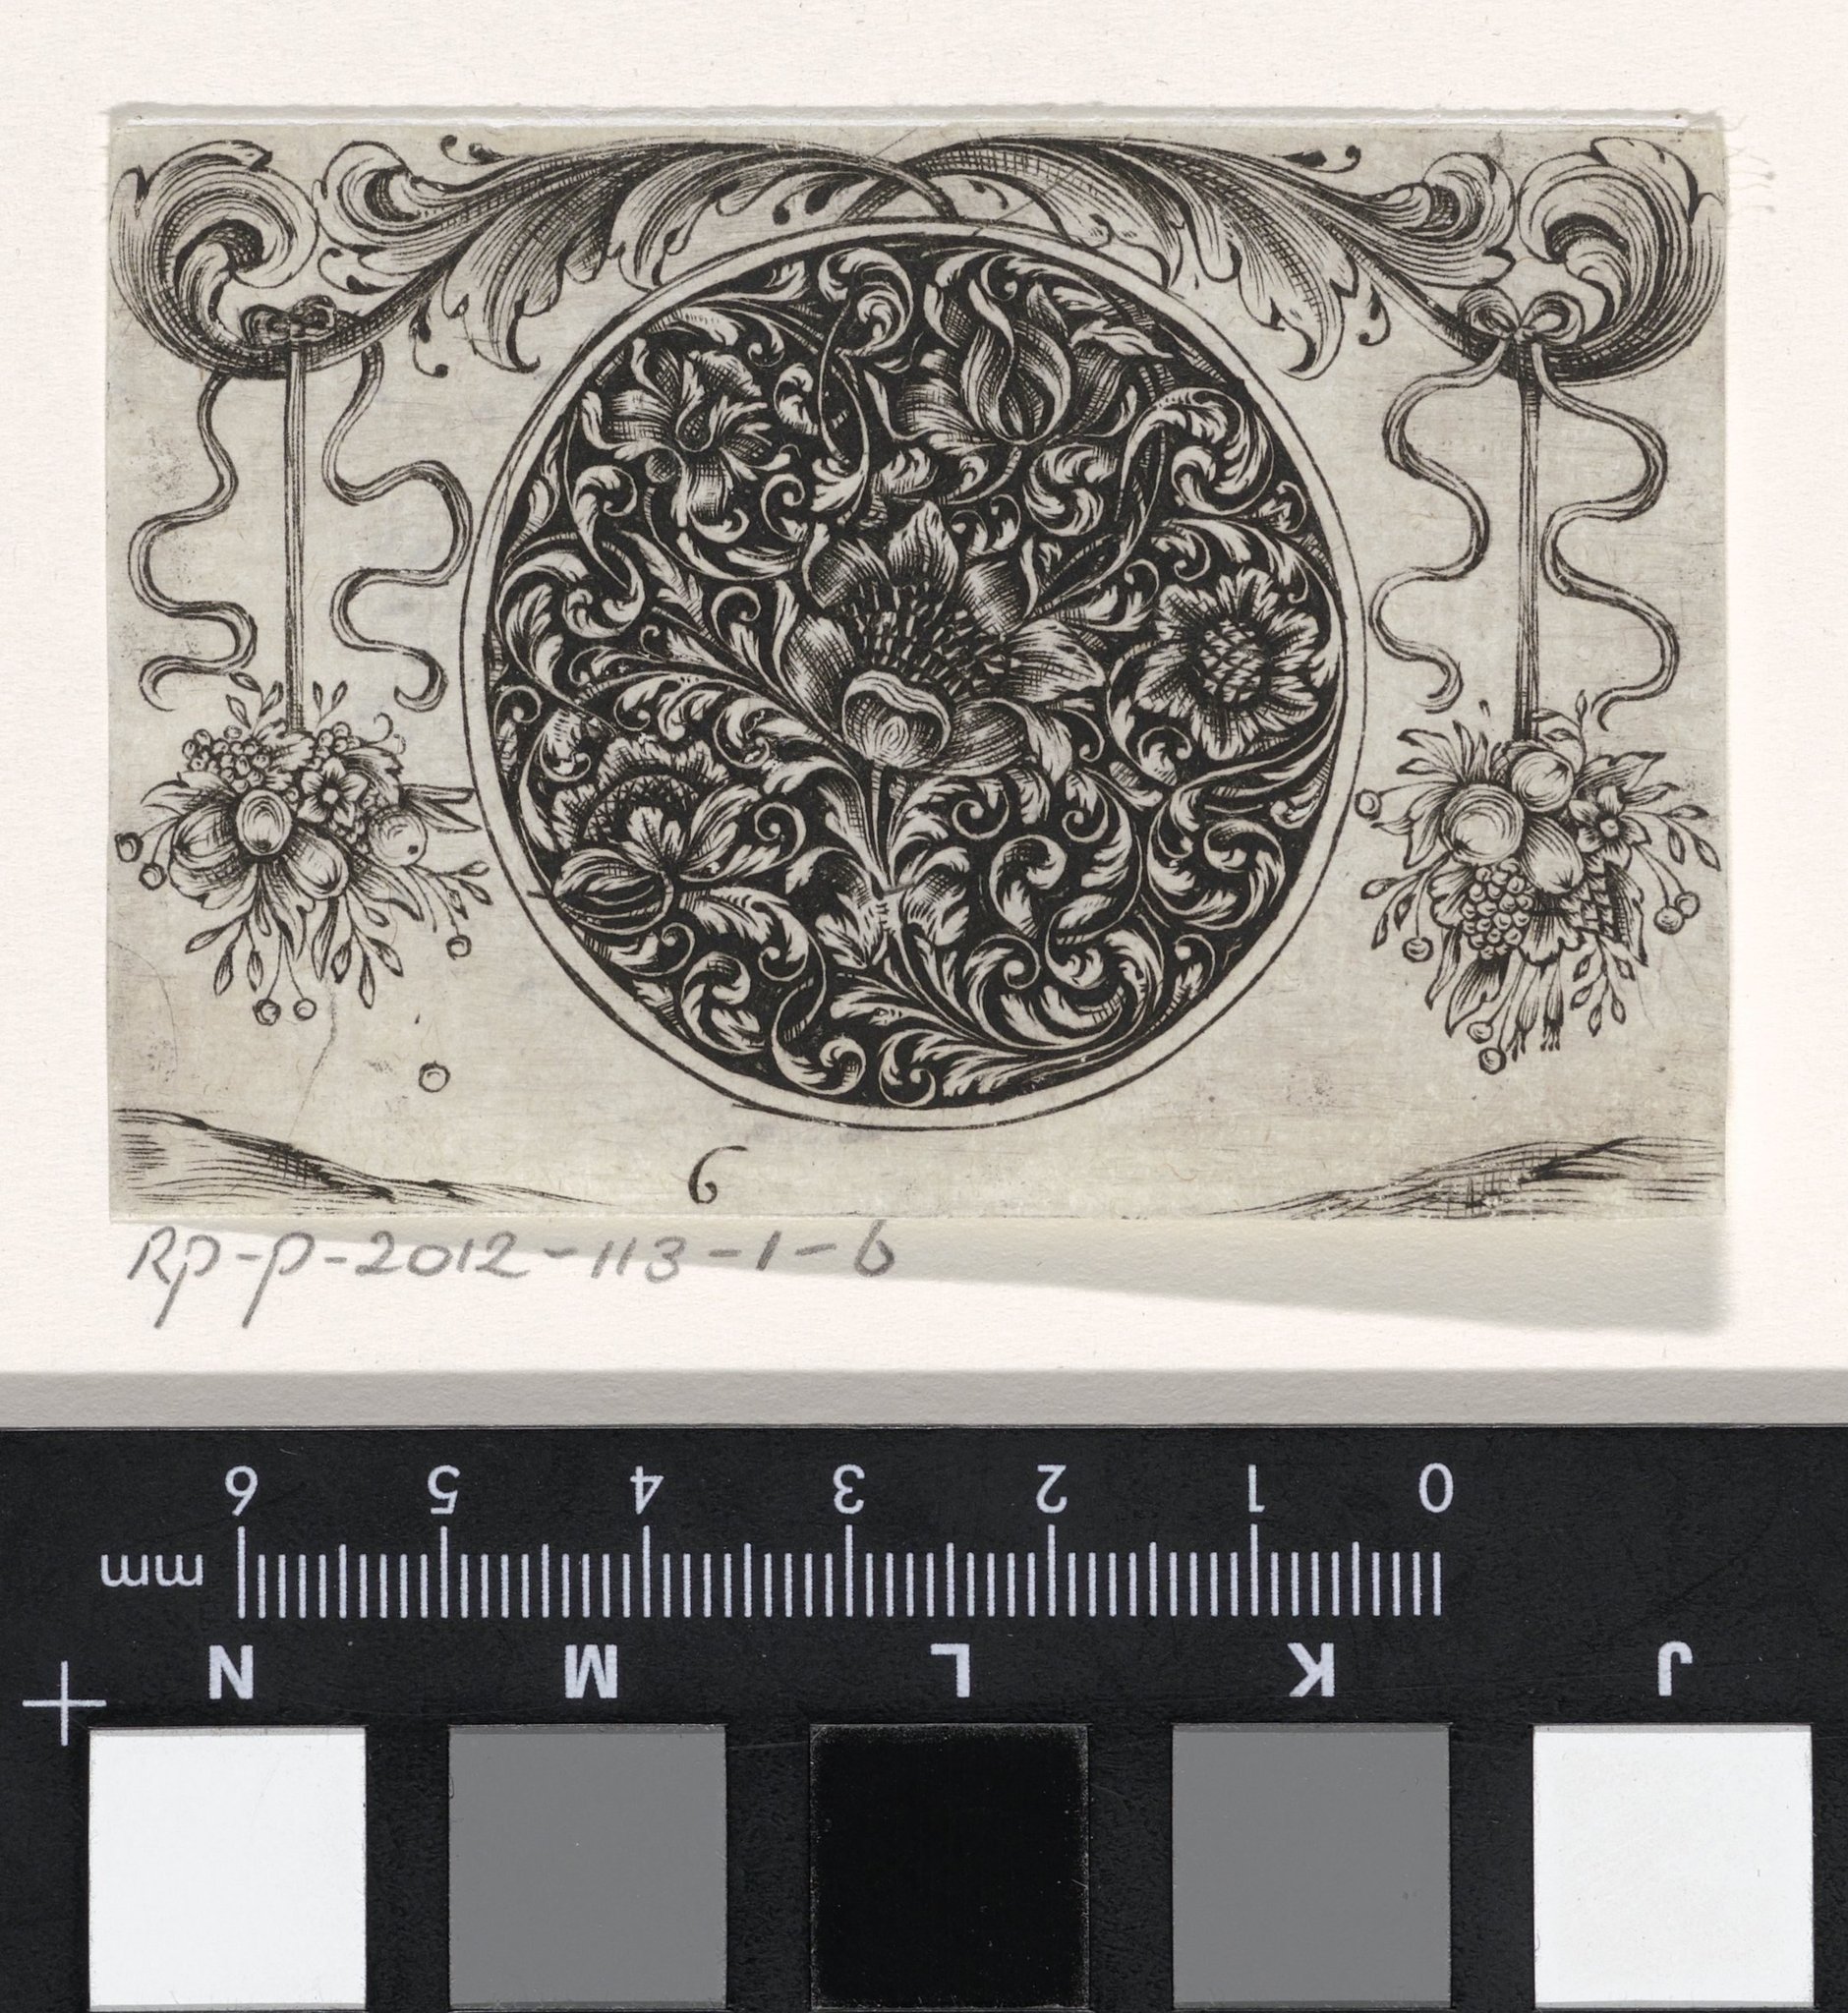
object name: ornament print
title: Rond medaillon met aan weerszijden een bloementros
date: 1647-1709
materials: paper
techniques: engraving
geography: nuremberg